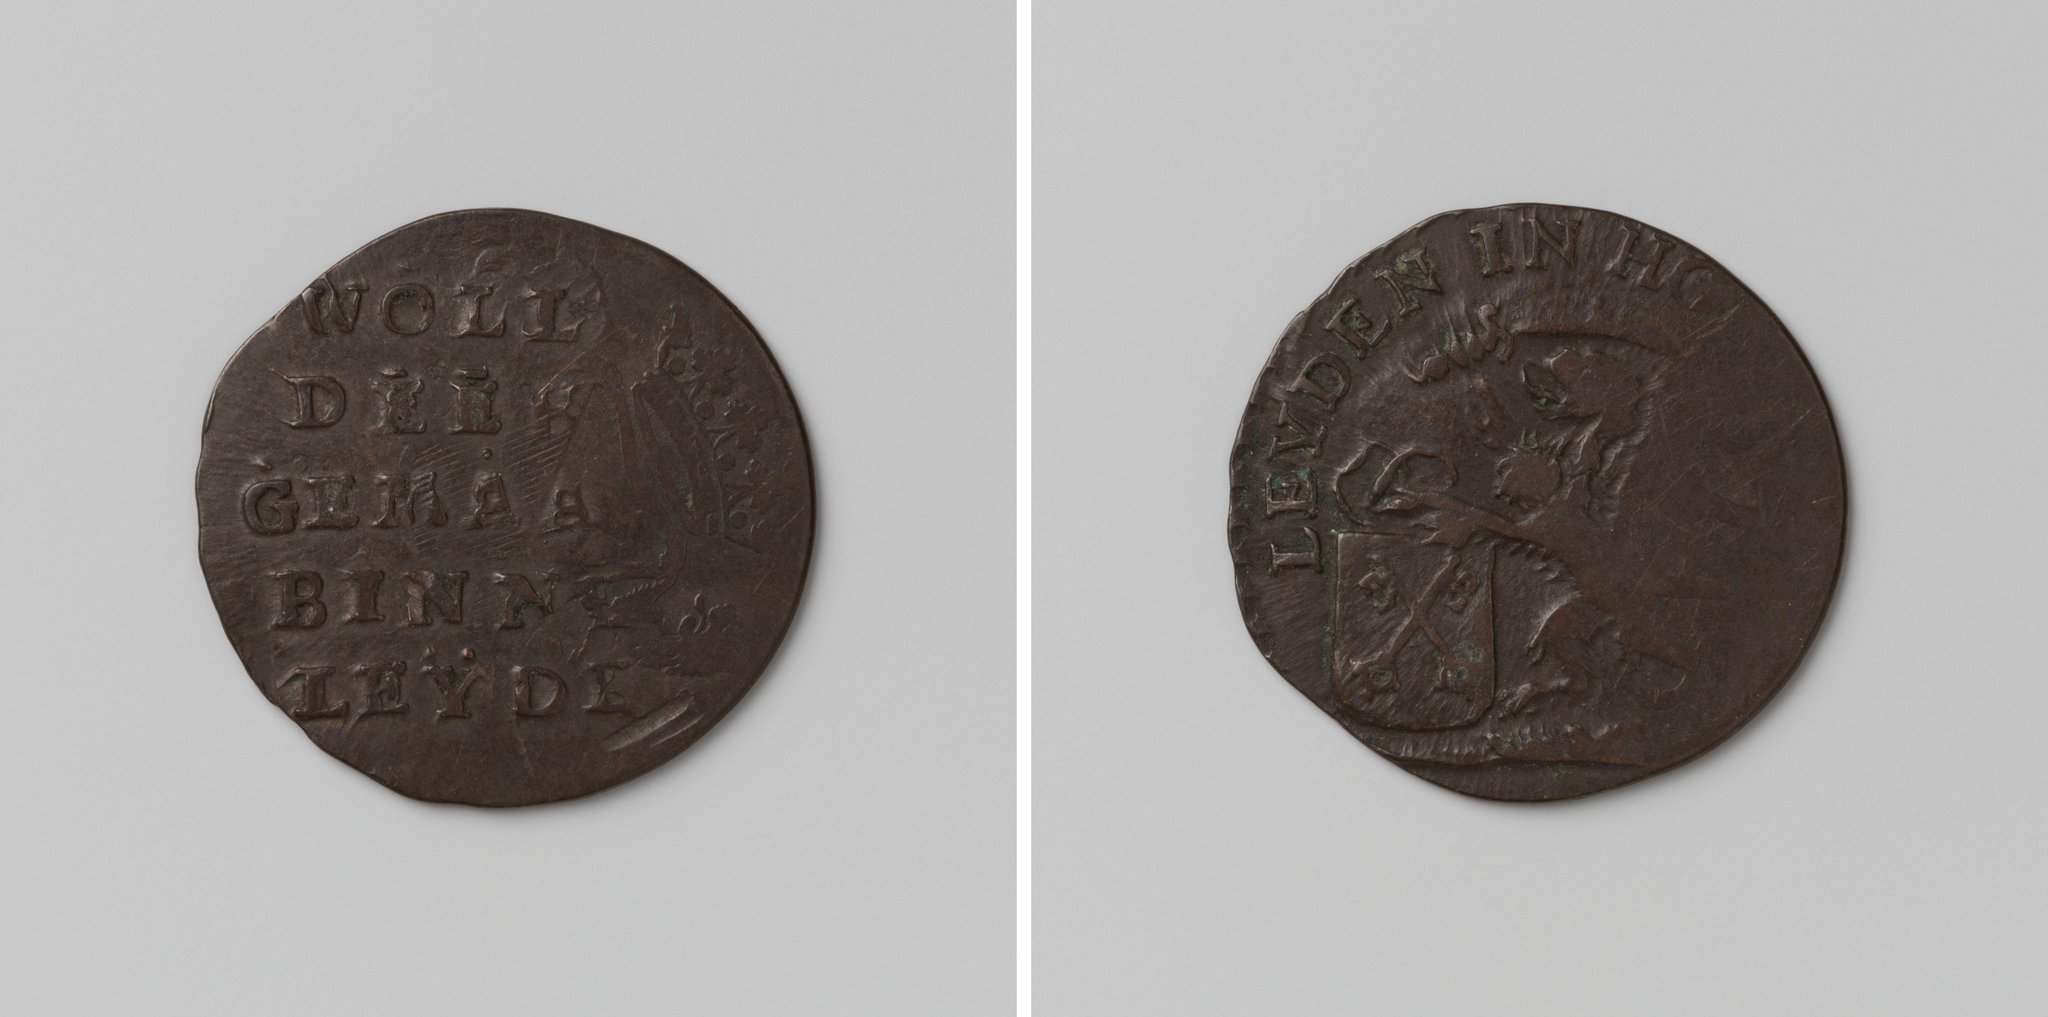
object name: coin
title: Wollenweversgilde van Leiden, uit Utrechtse duit vervaardigd merkloodje voor wollen dekens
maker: Anonymous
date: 1739-1794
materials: copper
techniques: striking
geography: leiden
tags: leiden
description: Koperen penning. Voorzijde: opschrift, geslagen over oudere voorstelling: gekroond wapenschild, geflankeerd door twee leeuwen. Keerzijde: leeuw met getrokken zwaard boven zijn hoofd en schild aan lint in linkerklauw, geslagen over ouder voorstelling: opschrift.